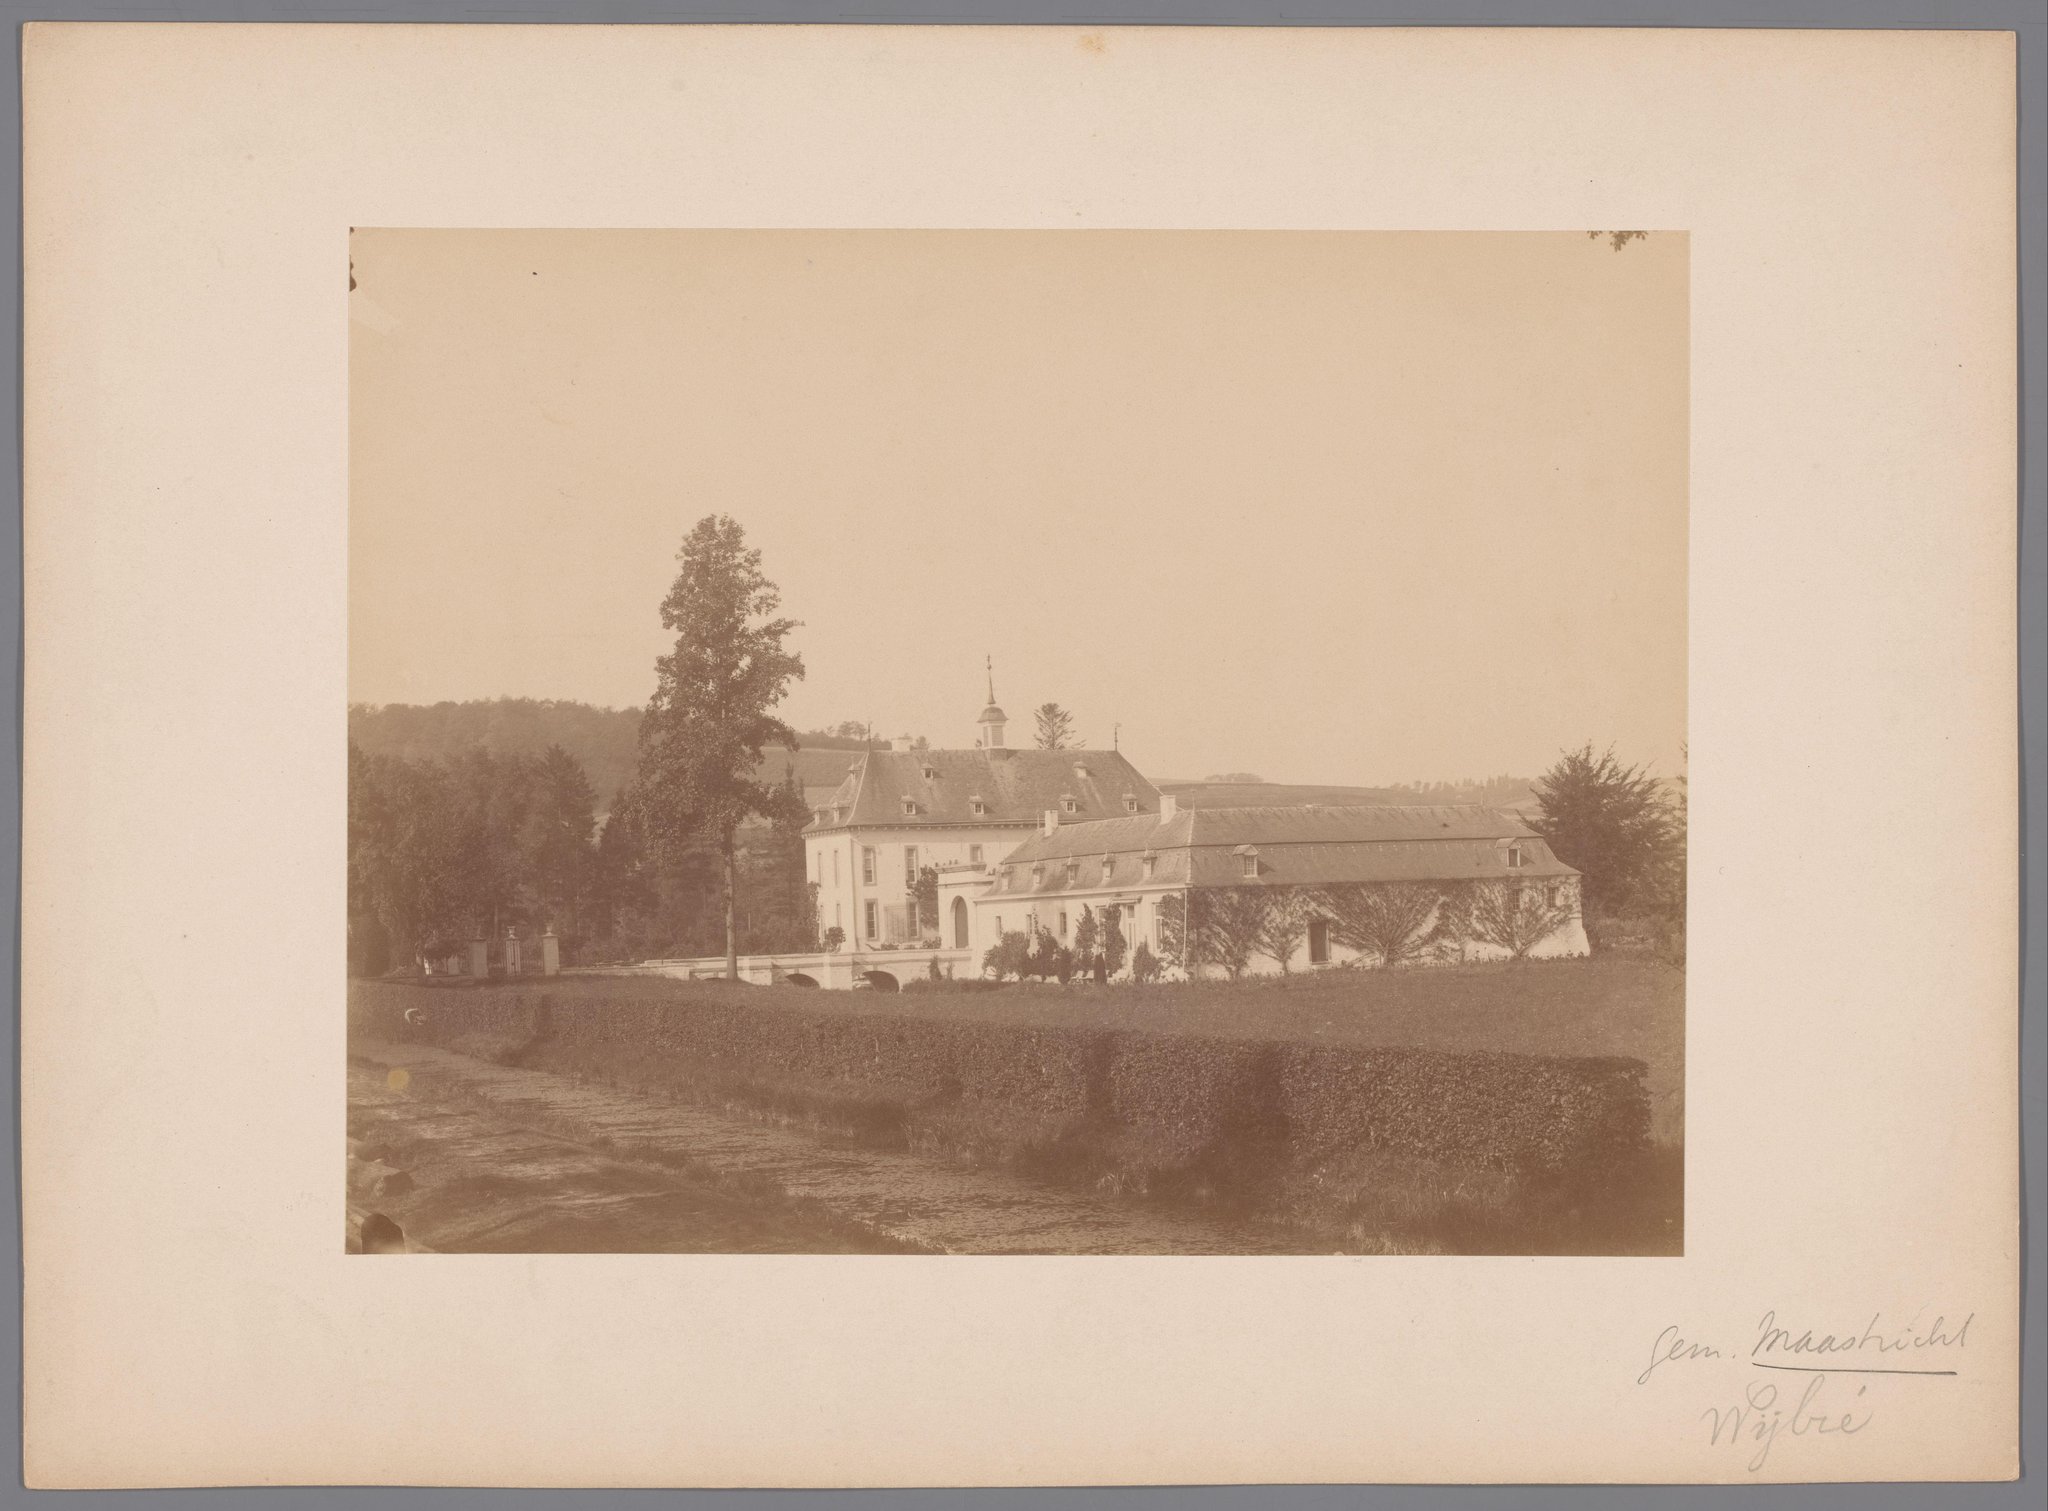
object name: photograph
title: Gezicht op Kasteel Wijlre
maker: anoniem (monumentenzorg)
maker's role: fotograaf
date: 1890-1920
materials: cardboard, photographic support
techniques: albumen print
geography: maastricht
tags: landscape with tower or castle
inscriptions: annotation: ‘gem. Maastricht/ Wijlre’, annotation: ‘Kasteel te Wijlre’